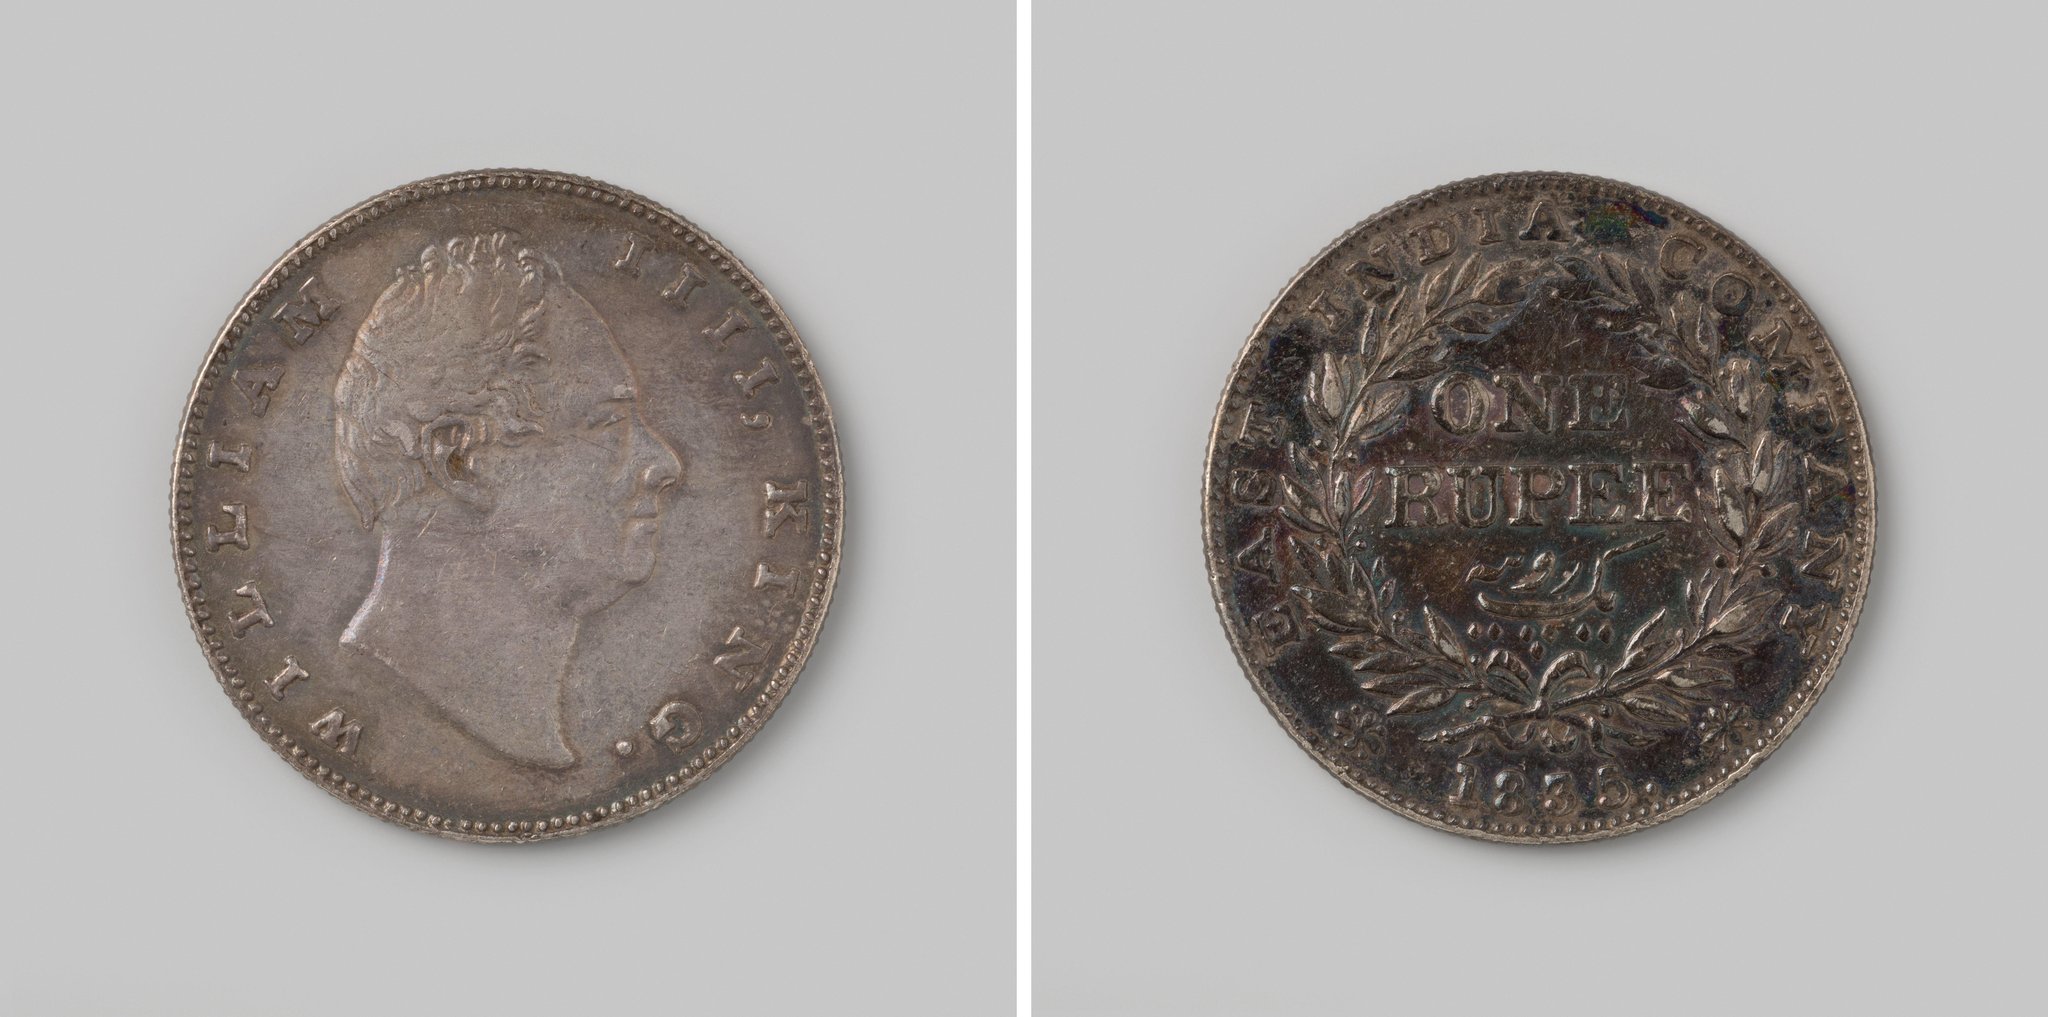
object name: coin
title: India, Engelse Oostindische Compagnie (EIC), op naam van koning William IV, roepie, 1835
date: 1835-1840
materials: silver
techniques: striking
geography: mumbai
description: Zilveren munt. Voorzijde: hoofd van koning William IV naar rechts. Op halsafsnede geen aanduiding. Keerzijde: tussen twee samengebonden takken in twee regels waarde-aanduiding: one rupee, waaronder in Arabische lettertekens in een regel waarde-aanduiding. Onderaan jaartal. Kartelrand.